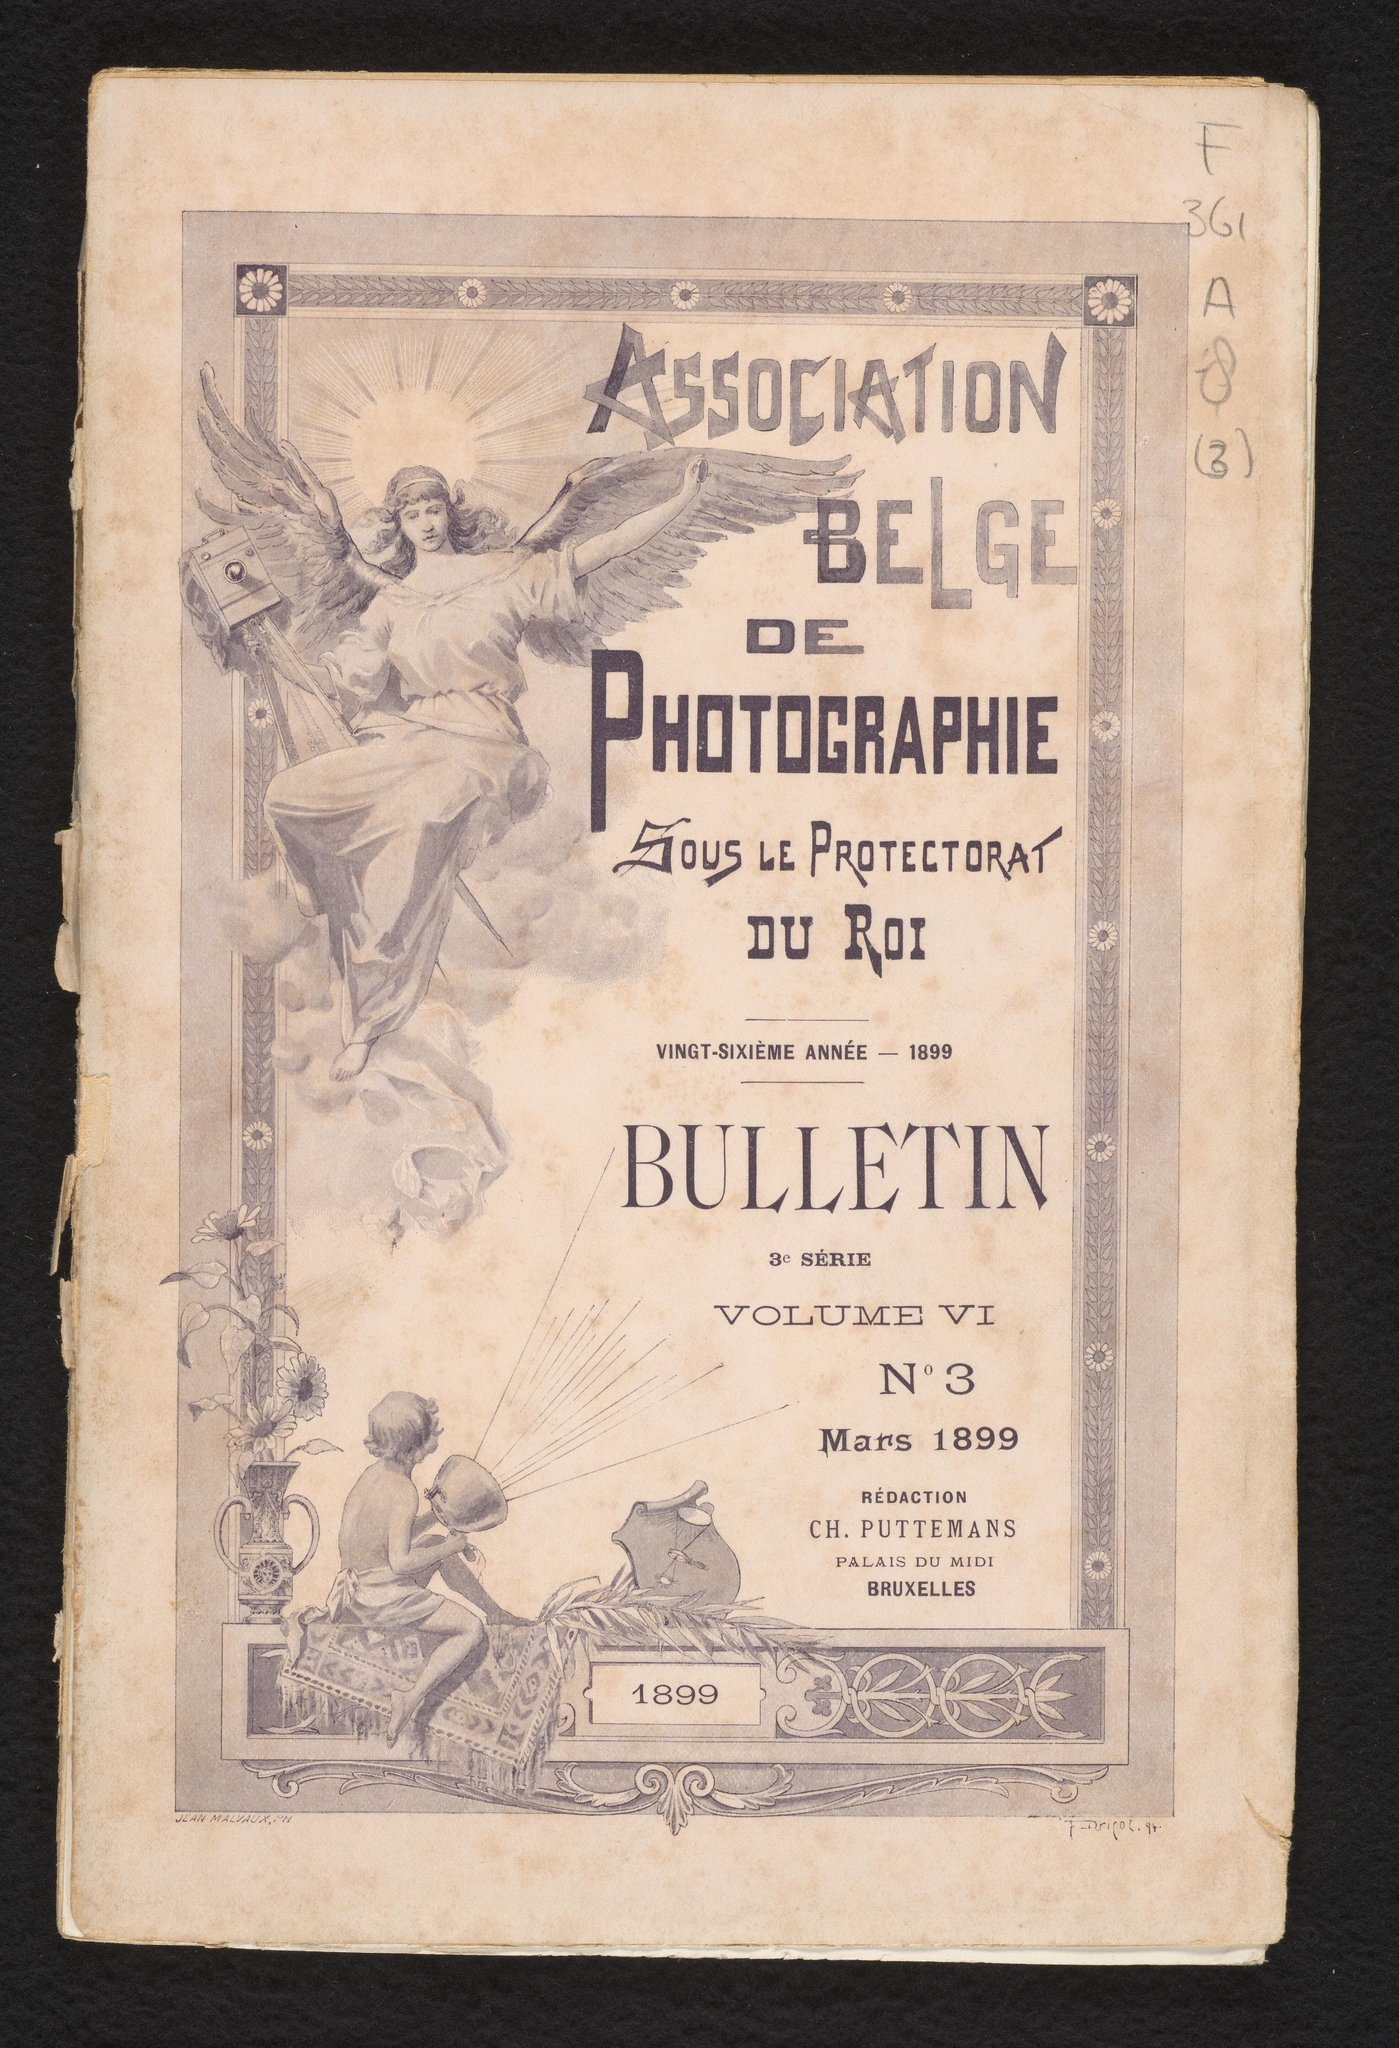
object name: book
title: Bulletin / Association belge de photographie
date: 1803-1899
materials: paper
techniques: printing, engraving